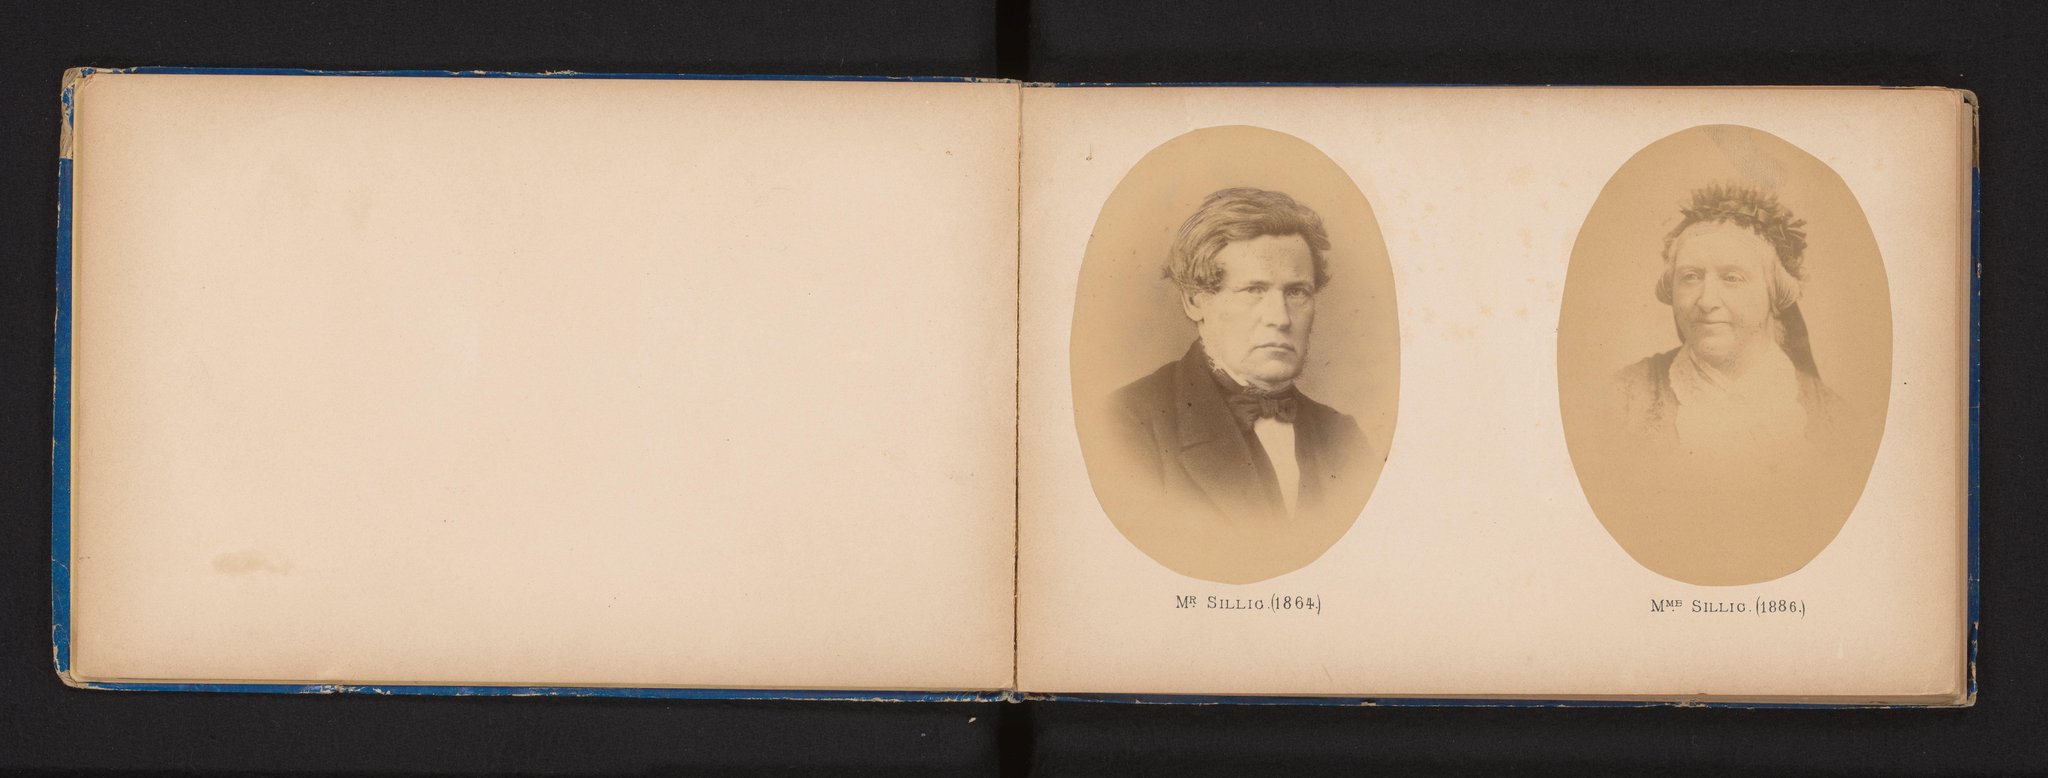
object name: photograph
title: Mr Sillig (1864) Mme Sillig (1886)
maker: Anonymous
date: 1864-1886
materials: photographic support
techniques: albumen print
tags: adult woman, adult man